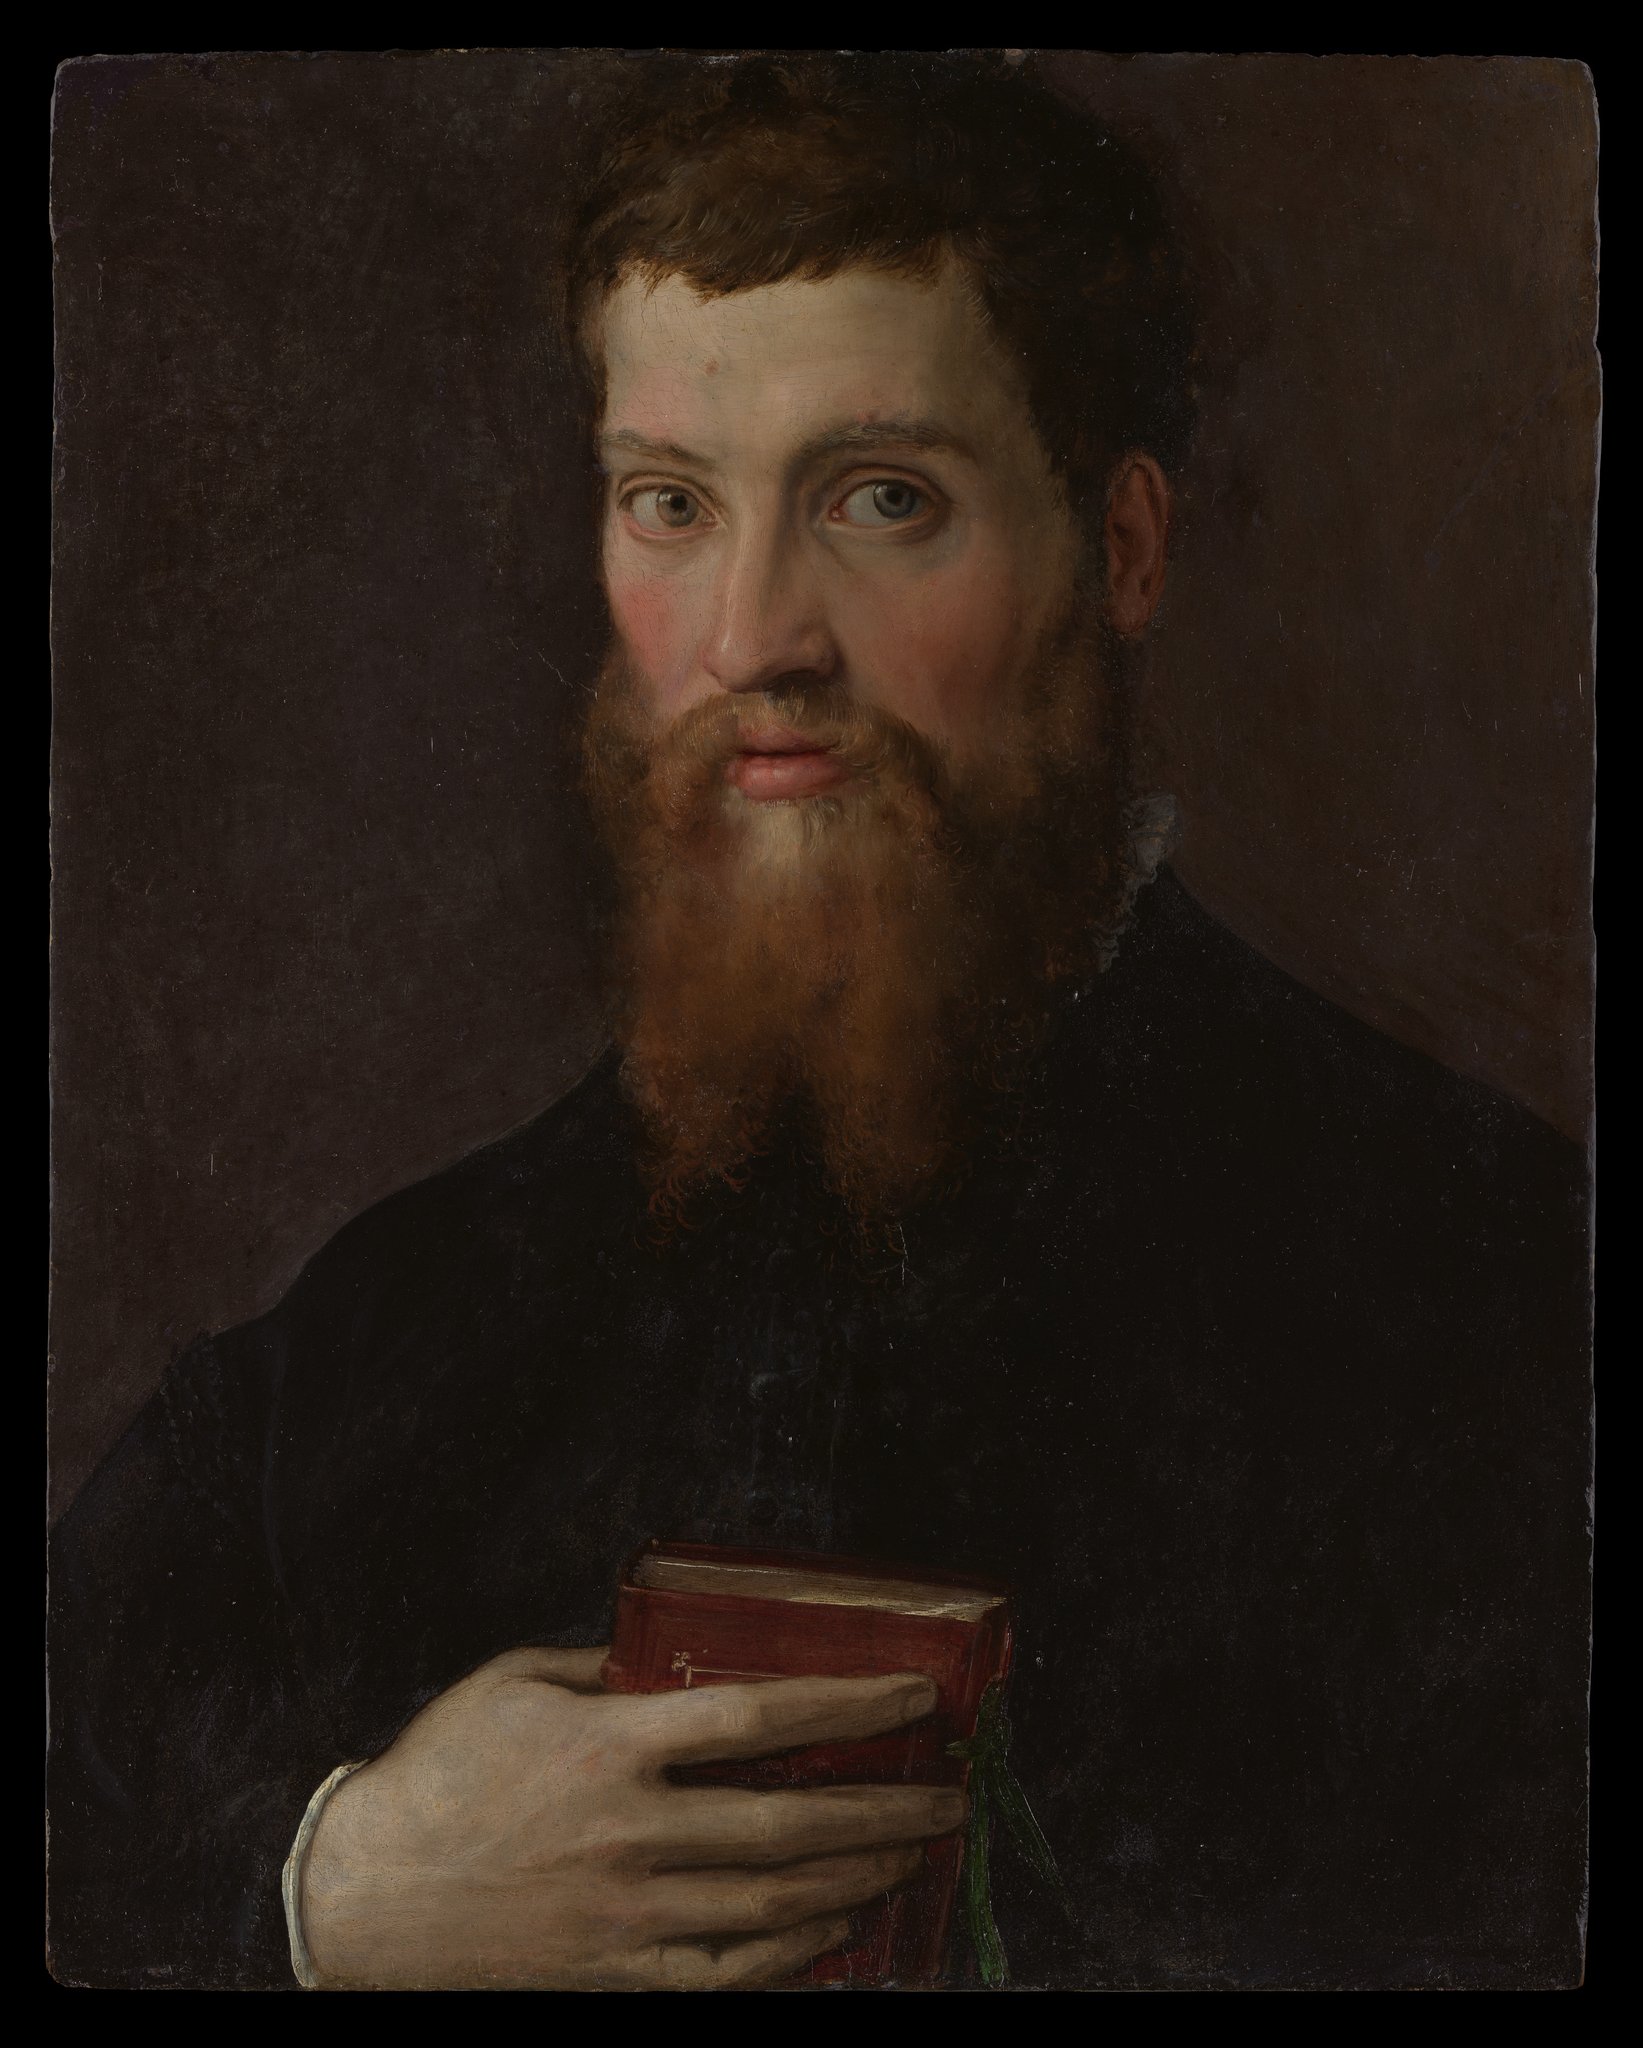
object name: painting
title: Carlo Rimbotti (1518–1591)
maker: francesco salviati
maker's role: artist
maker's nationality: italian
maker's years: 1510-1563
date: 1548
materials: oil, wood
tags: men,portraits